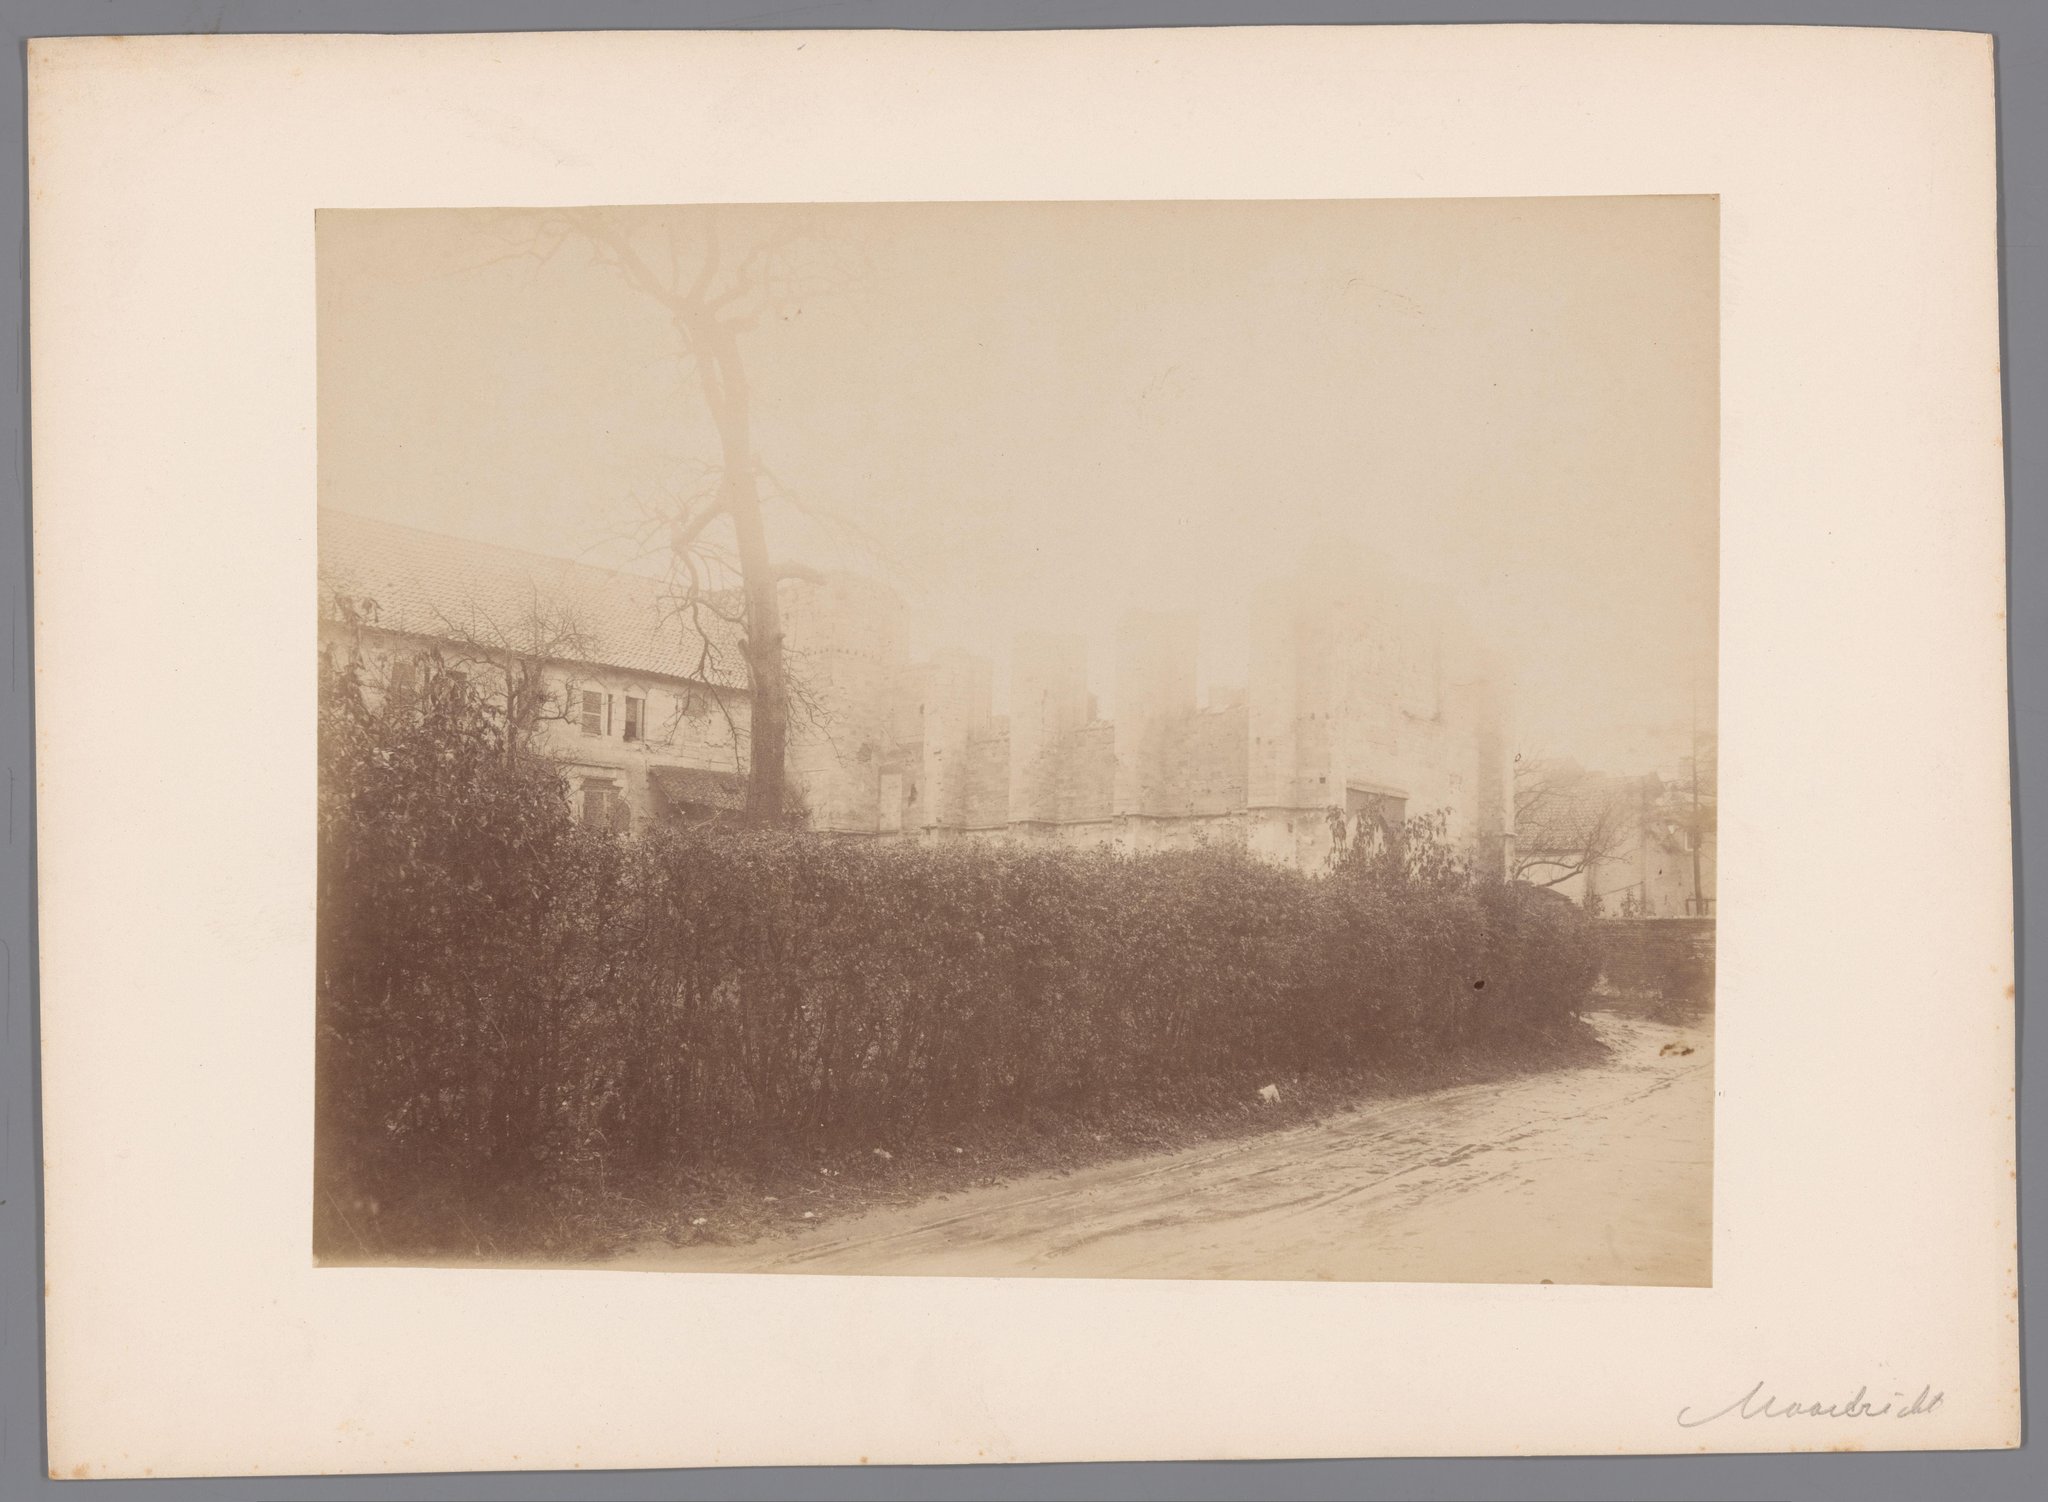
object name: photograph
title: Noordwestzijde van het oude Beyart klooster te Maastricht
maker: anoniem (monumentenzorg)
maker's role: fotograaf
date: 1893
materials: cardboard, photographic support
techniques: albumen print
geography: maastricht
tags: ruin of church, monastery, etc.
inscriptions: annotation: ‘Maastricht’, annotation: ‘Maastricht (L.)/ Beyaert gebouwen/ N.W. zijde v/d kerk/ Nov 1893’